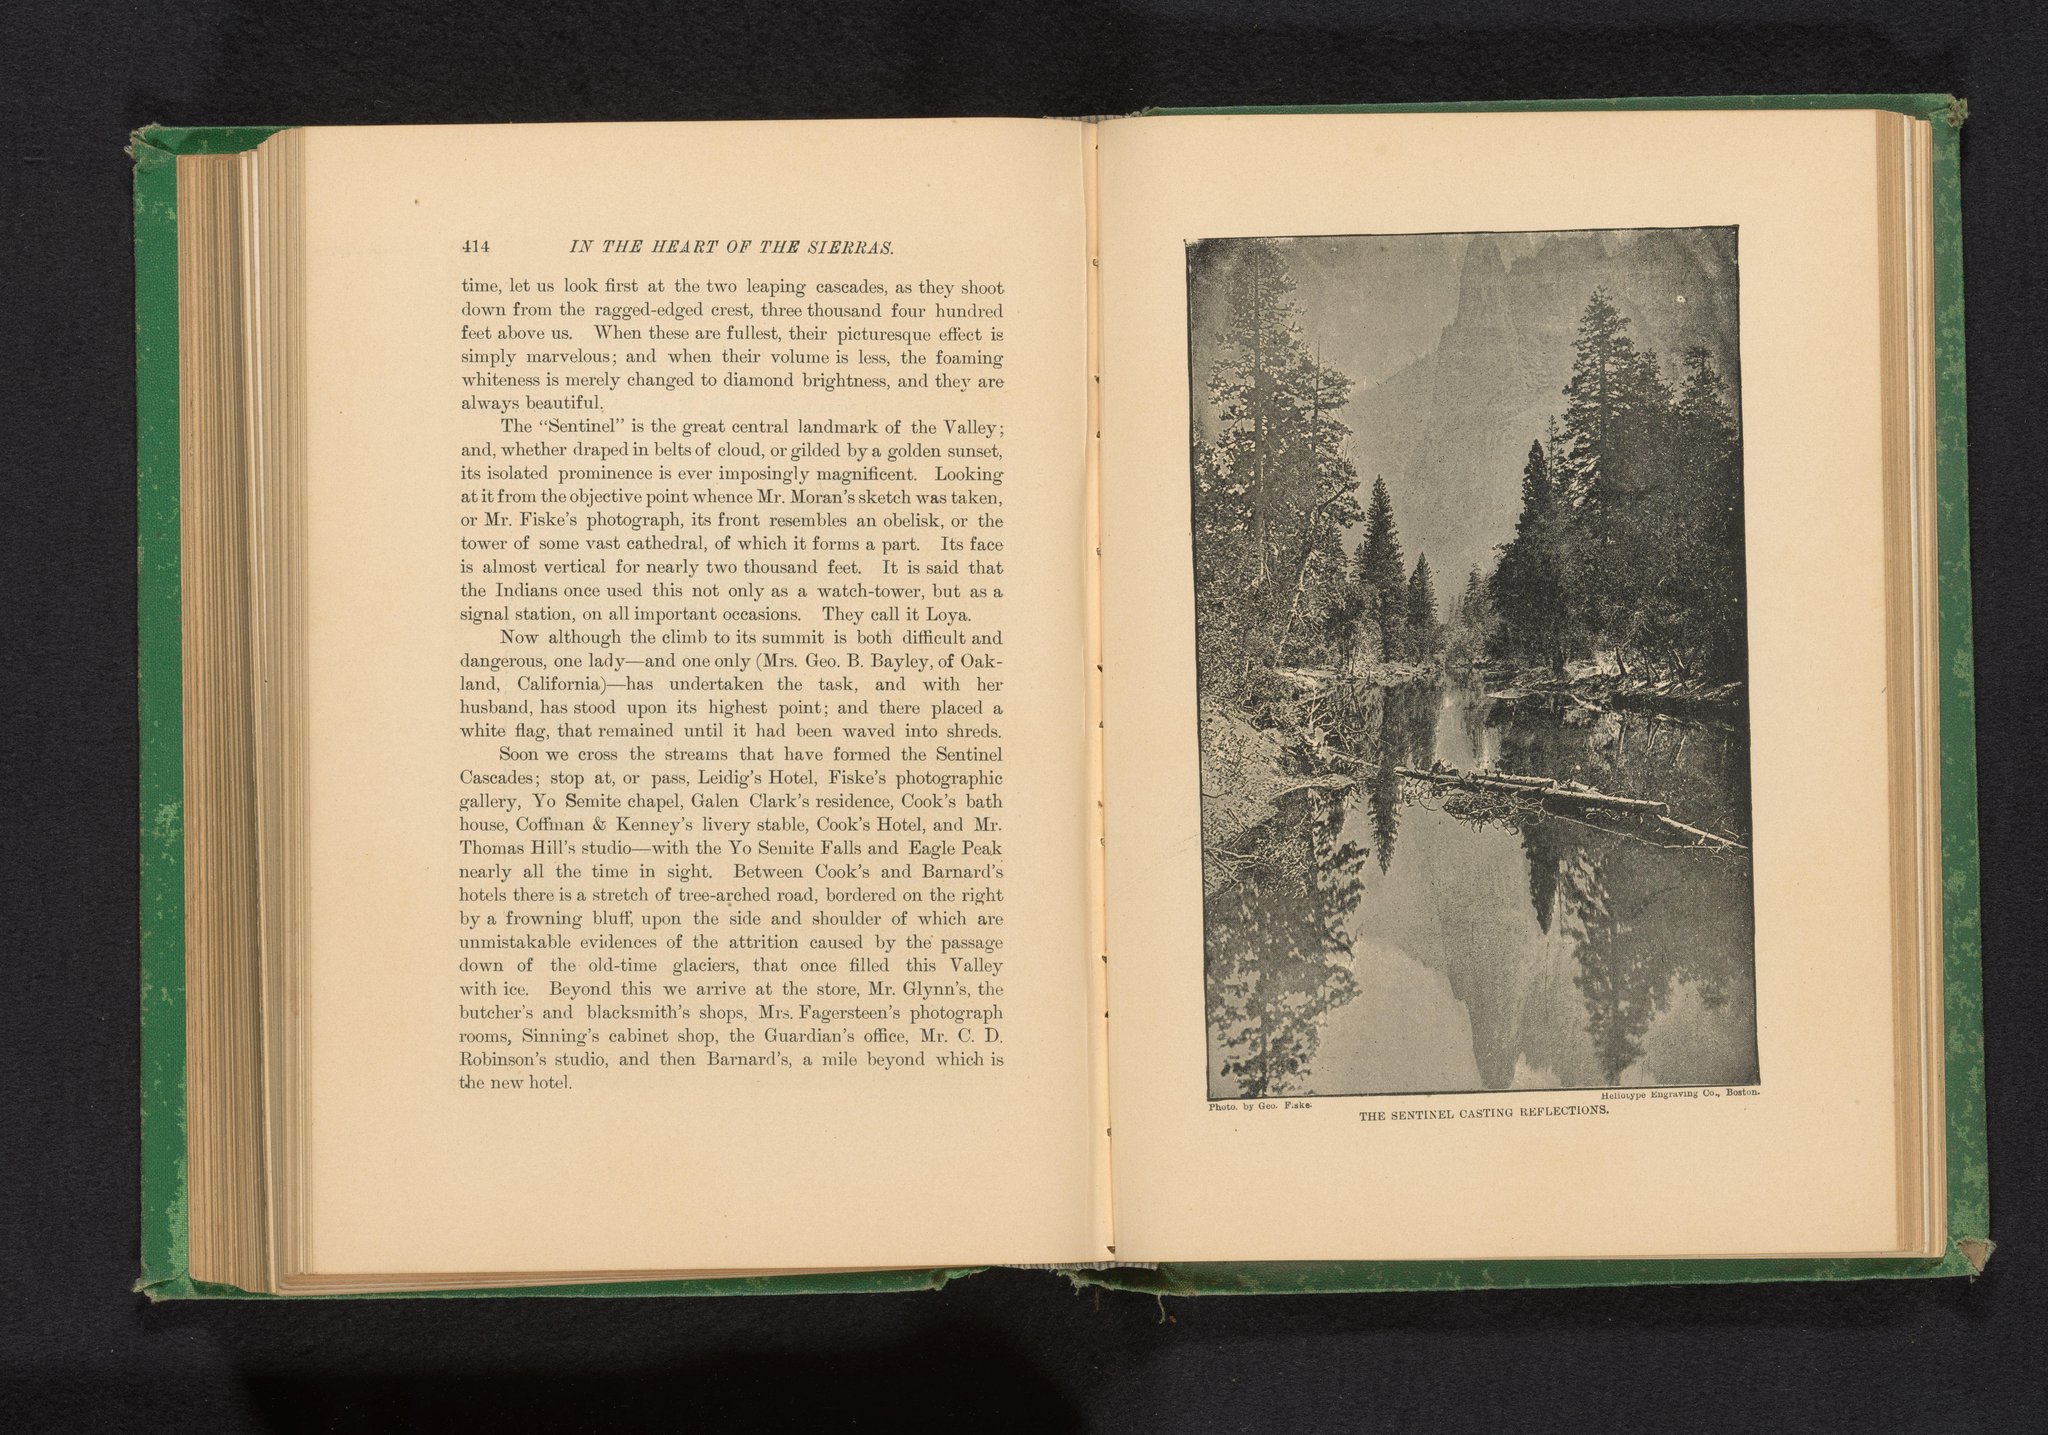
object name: page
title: The Sentinel Casting Reflections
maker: george fiske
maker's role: fotograaf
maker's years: 1835-1918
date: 1881-1886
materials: paper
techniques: printing block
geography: yosemite valley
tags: river, mountains